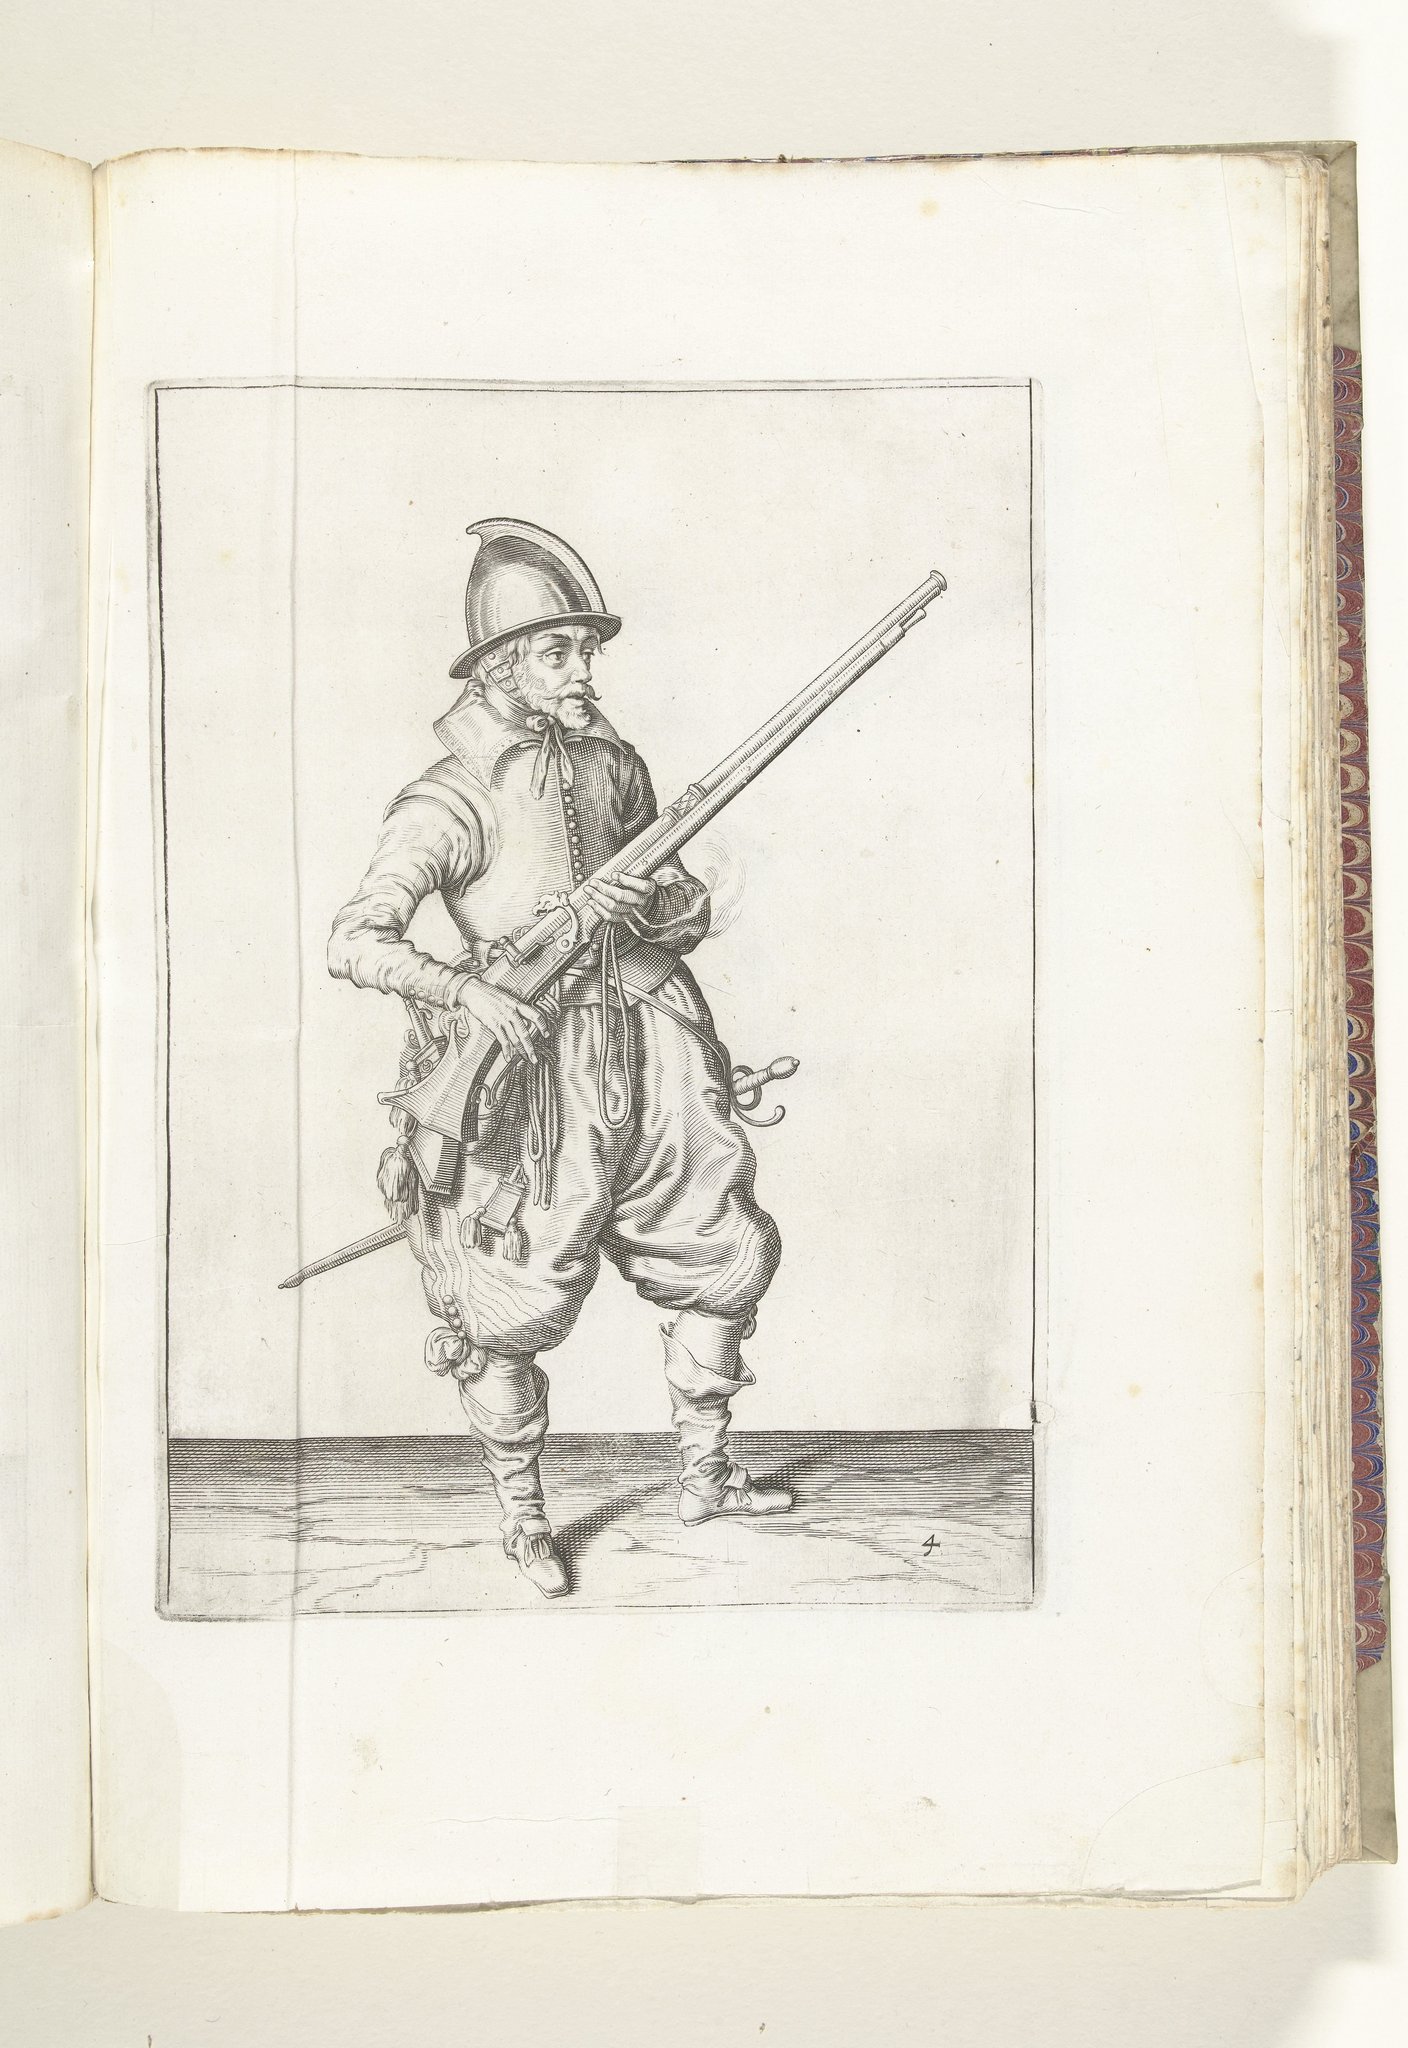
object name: print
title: Soldaat die zijn roer met zijn linkerhand bij zijn rechterzijde vasthoudt (nr. 4), ca. 1600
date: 1597-1607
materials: paper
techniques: engraving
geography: northern netherlands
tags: the hague, maurice (prince of orange), handling of weapons ~ military training, weapons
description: Een soldaat, ten voeten uit, naar rechts, die een roer (een bepaald type vuurwapen) met zijn linkerhand bij zijn rechterzijde vasthoudt (nr. 4), ca. 1600. In zijn linkerhand behalve het roer ook een brandende lont. Zijn rechterhand losjes bij de trekker van het roer. Plaat 4 in de instructies voor het hanteren van de roer. Onderdeel van de illustraties in: J. de Gheyn, Wapenhandelinghe van Roers Musquetten ende spiessen, Amsterdam, 1608. Krijgswezen rond 1600.